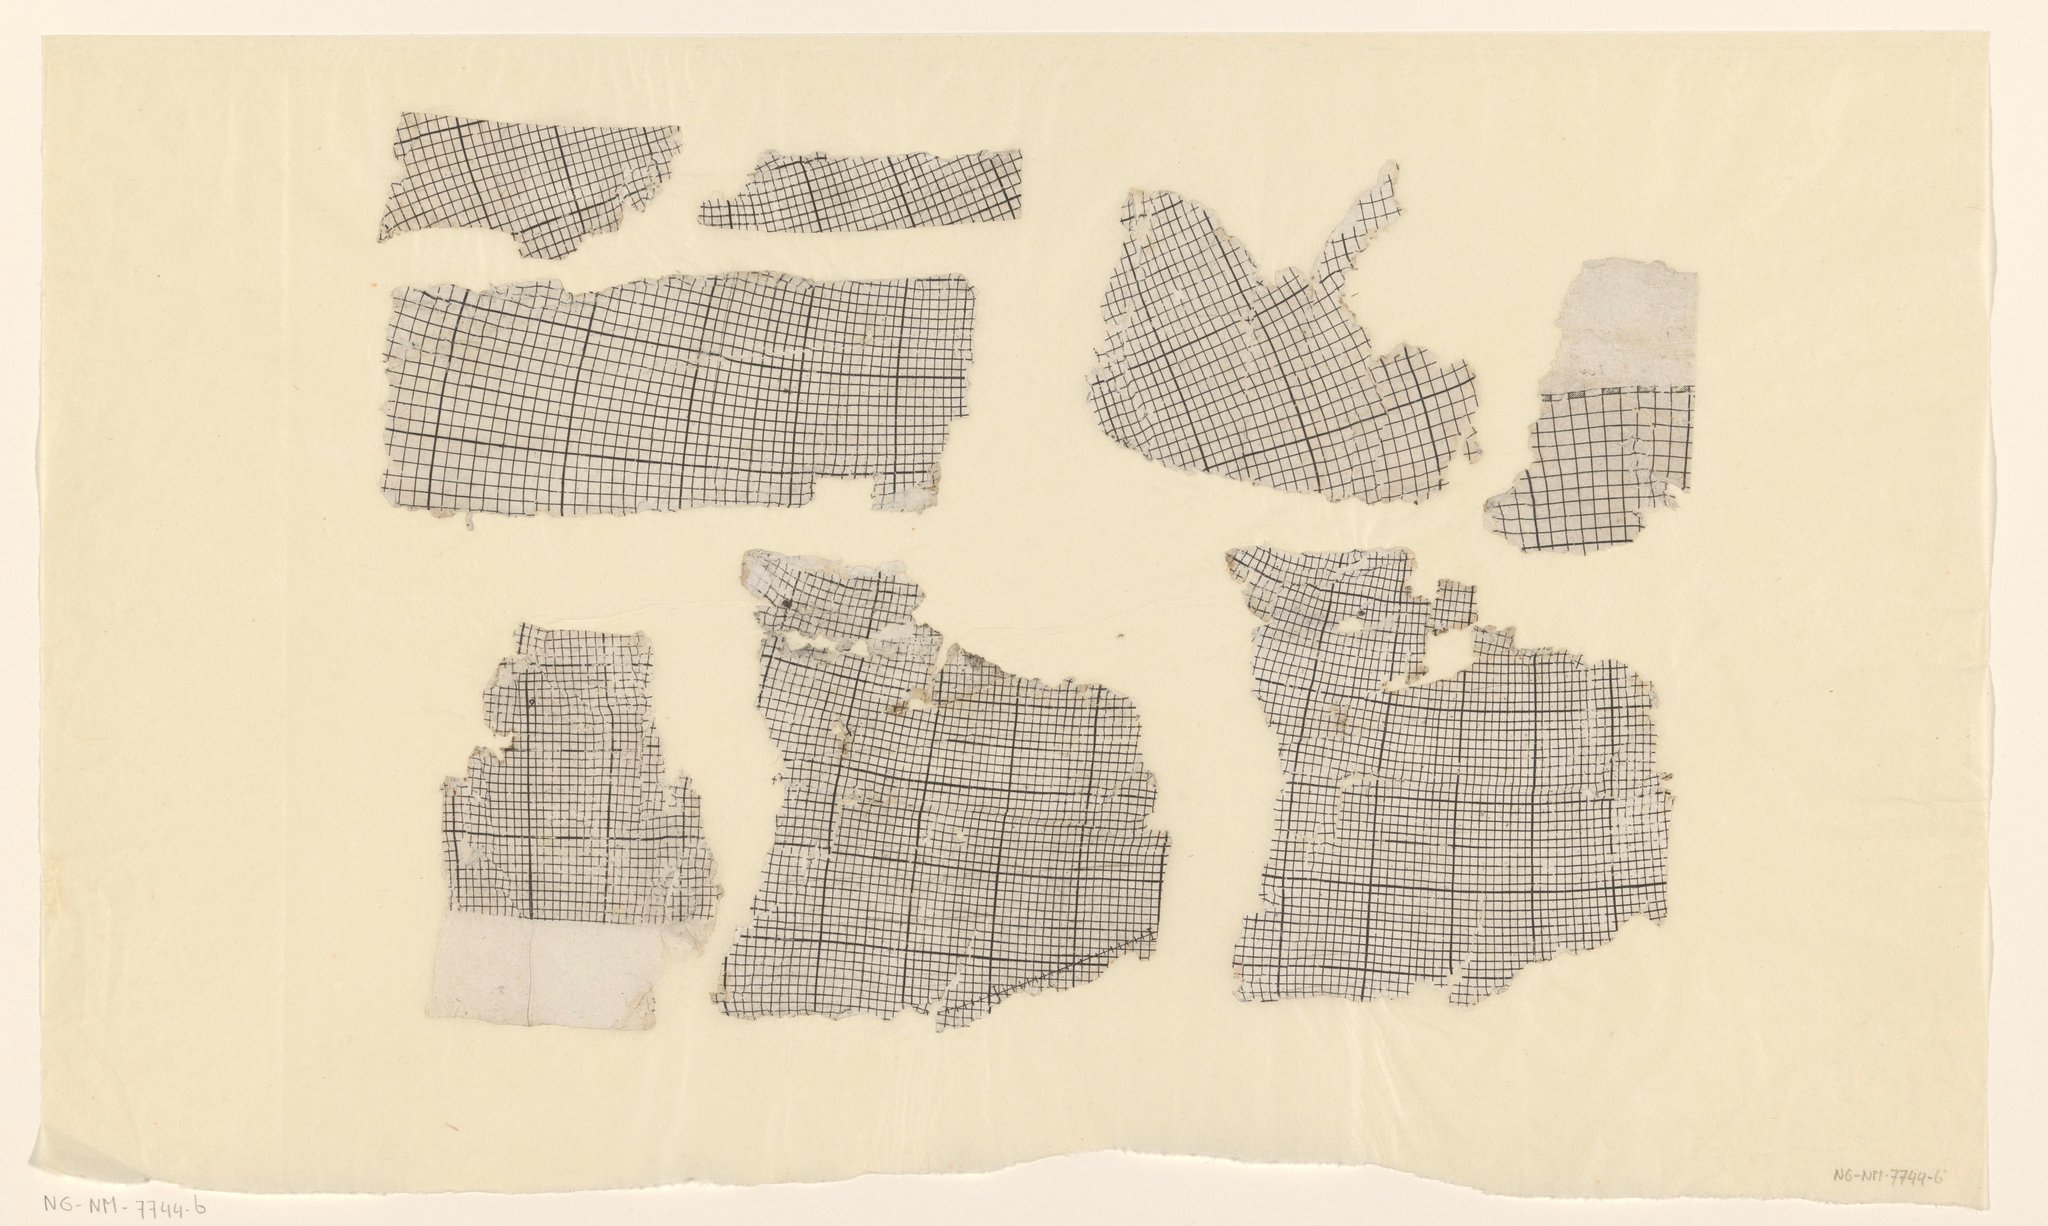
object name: map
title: Fragmenten van kaartnet van noordelijk halfrond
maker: Anonymous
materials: paper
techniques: engraving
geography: northern netherlands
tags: maps, atlases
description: De prenten en kaarten in de Nova Zembla collectie zijn tijdens een expeditie van Willem Barendsz en Jacob van Heemskerk in 1596-1597 noodgedwongen in het winterkamp, het ‘Behouden Huis’, op het eiland achtergelaten. Bijna drie eeuwen later, in 1871, keerde de Noor Elling Carlsen terug naar Nova Zembla en vond daar de restanten van het ‘Behouden Huis, inclusief een groot deel van de inventaris. Een deel van de prenten, in de vorm van aaneengekoekte kluiten, werd toen ook teruggevonden. De papierkluiten waren soms op meerdere plekken gebroken. Tussen 1975-1979 zijn de prenten van elkaar gescheiden. Dit leverde in totaal ca. 1000 fragmenten van ca. 400 afdrukken van ca. 150 verschillende prenten op. Voor zover mogelijk zijn de fragmenten samengevoegd en zijn de prenten gereconstrueerd.